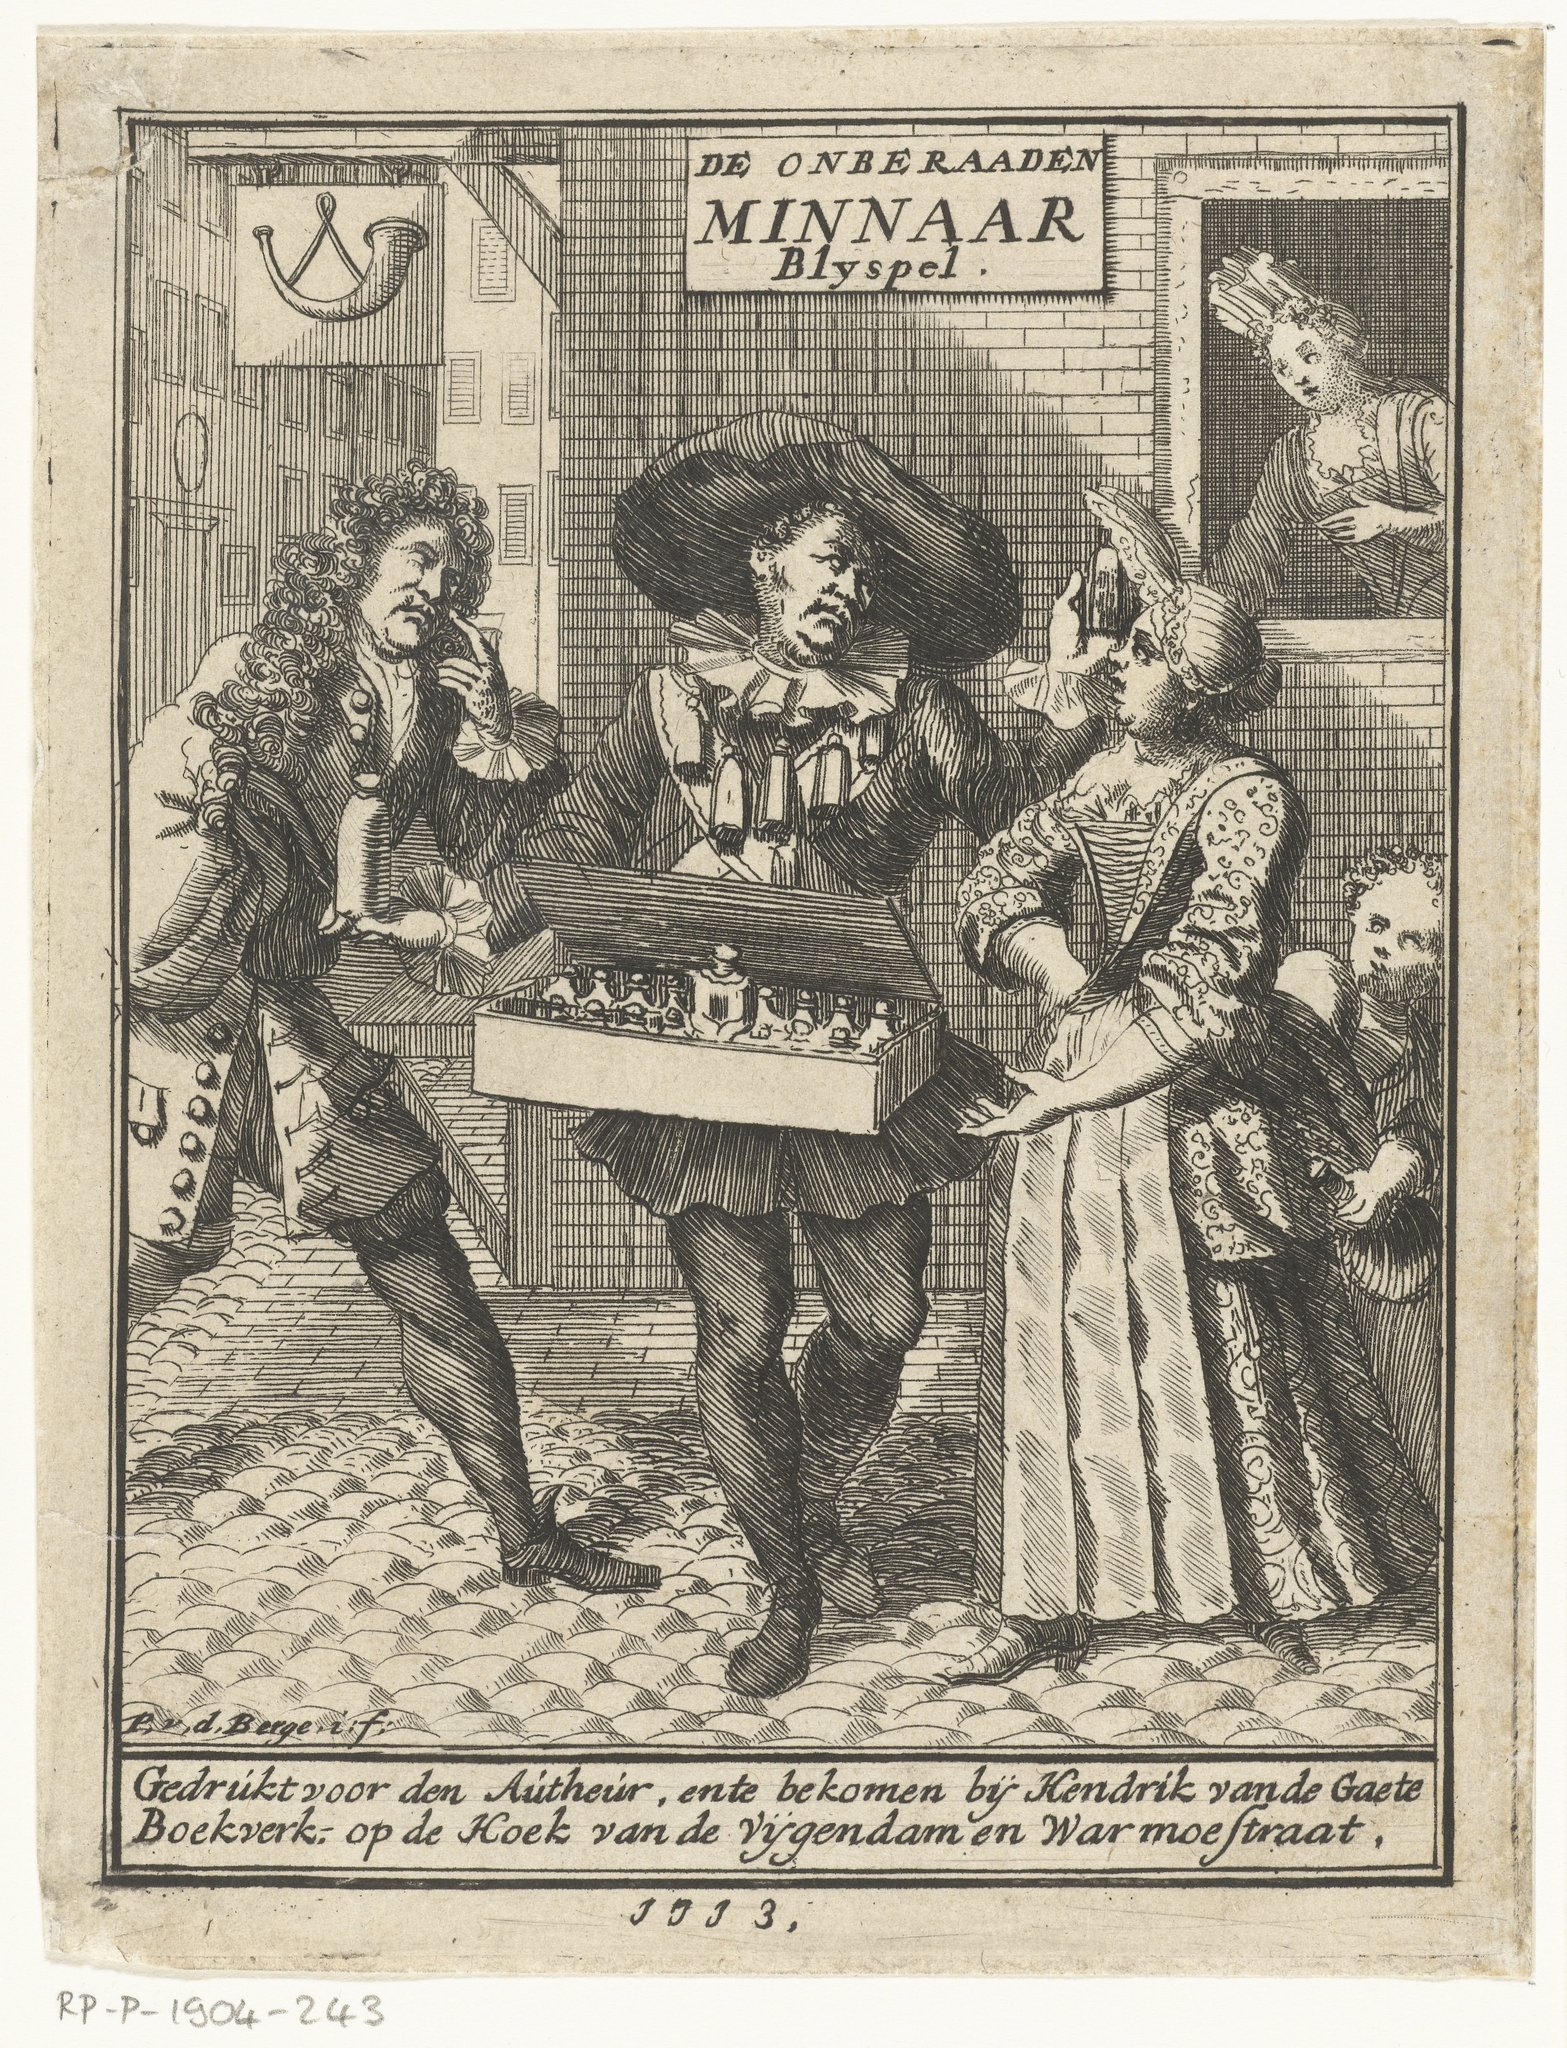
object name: print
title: Titelpagina voor: H. van Halmael, De onberaaden minnaar, Amsterdam, 1713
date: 1713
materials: paper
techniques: etching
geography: amsterdam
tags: pedlar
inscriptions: collector's mark: Lugt 2228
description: Een straatventer met een bak met flesjes reukwater staat tussen een vrouw en een man in en prijst zijn waar aan. Een tweede vrouw kijkt geïnteresseerd uit haar raam.